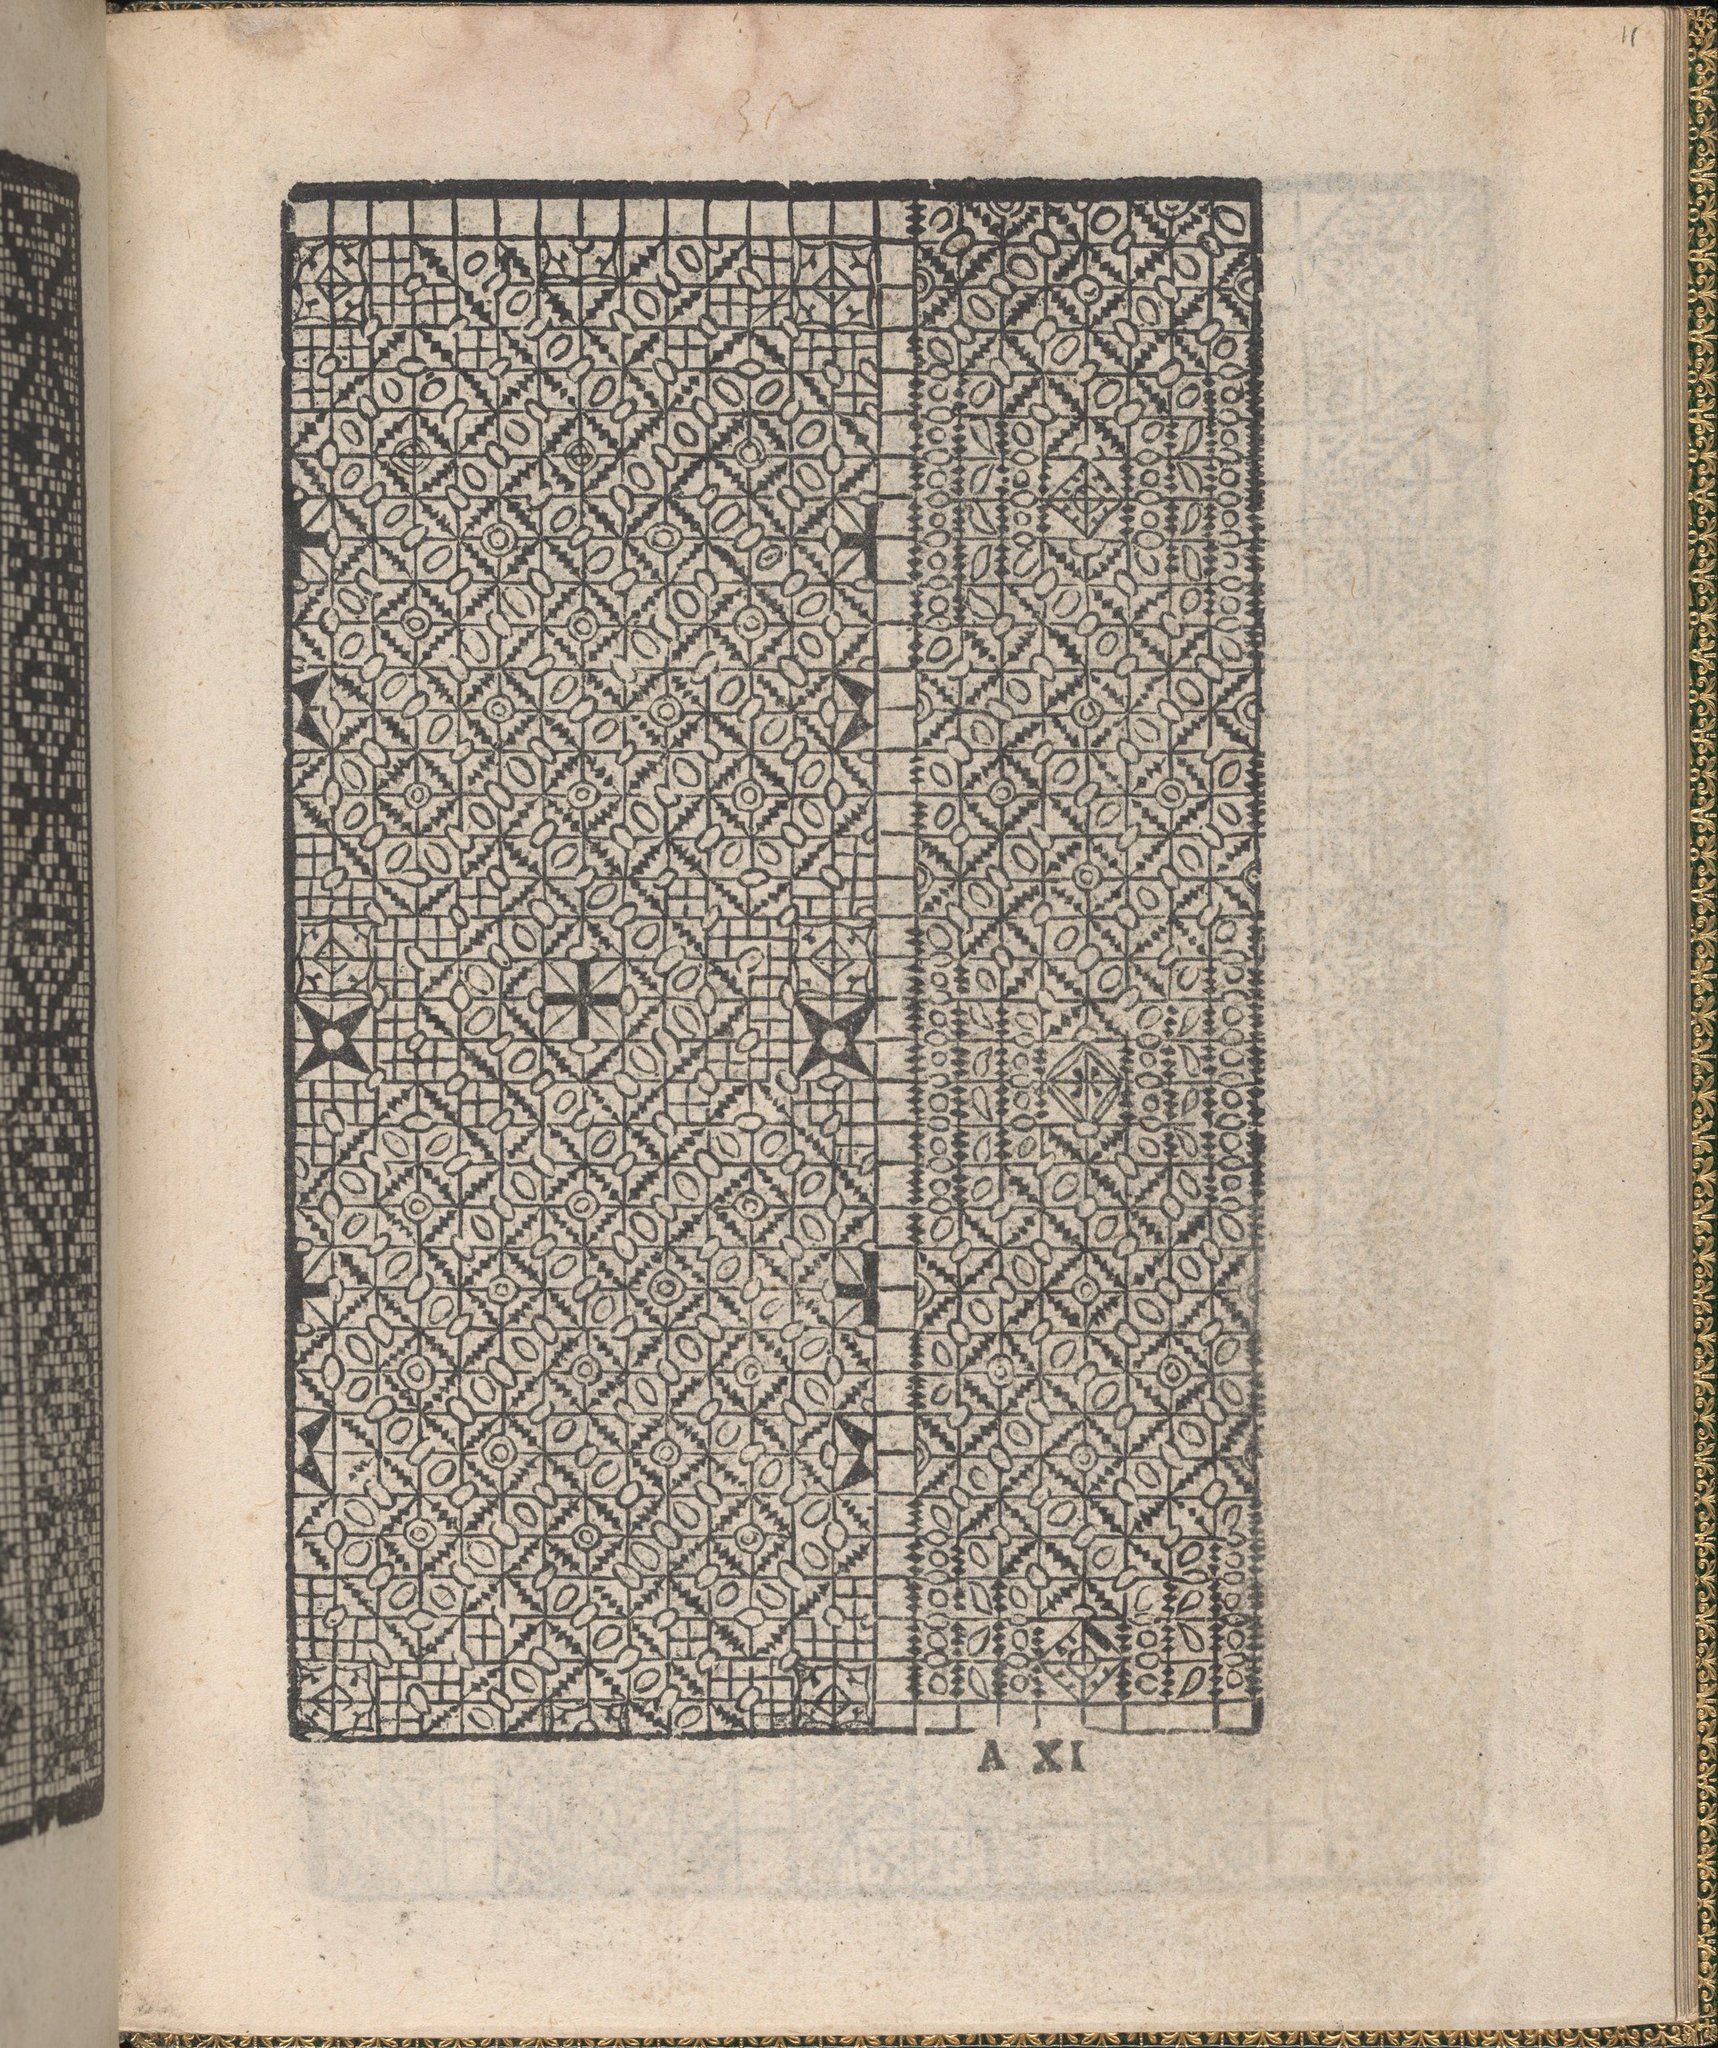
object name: book print ornament architecture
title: Ornamento delle belle & virtuose donne, page 6 (verso)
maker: matteo pagano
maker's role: publisher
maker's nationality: italian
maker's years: 1515-1588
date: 1554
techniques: woodcut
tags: ornament